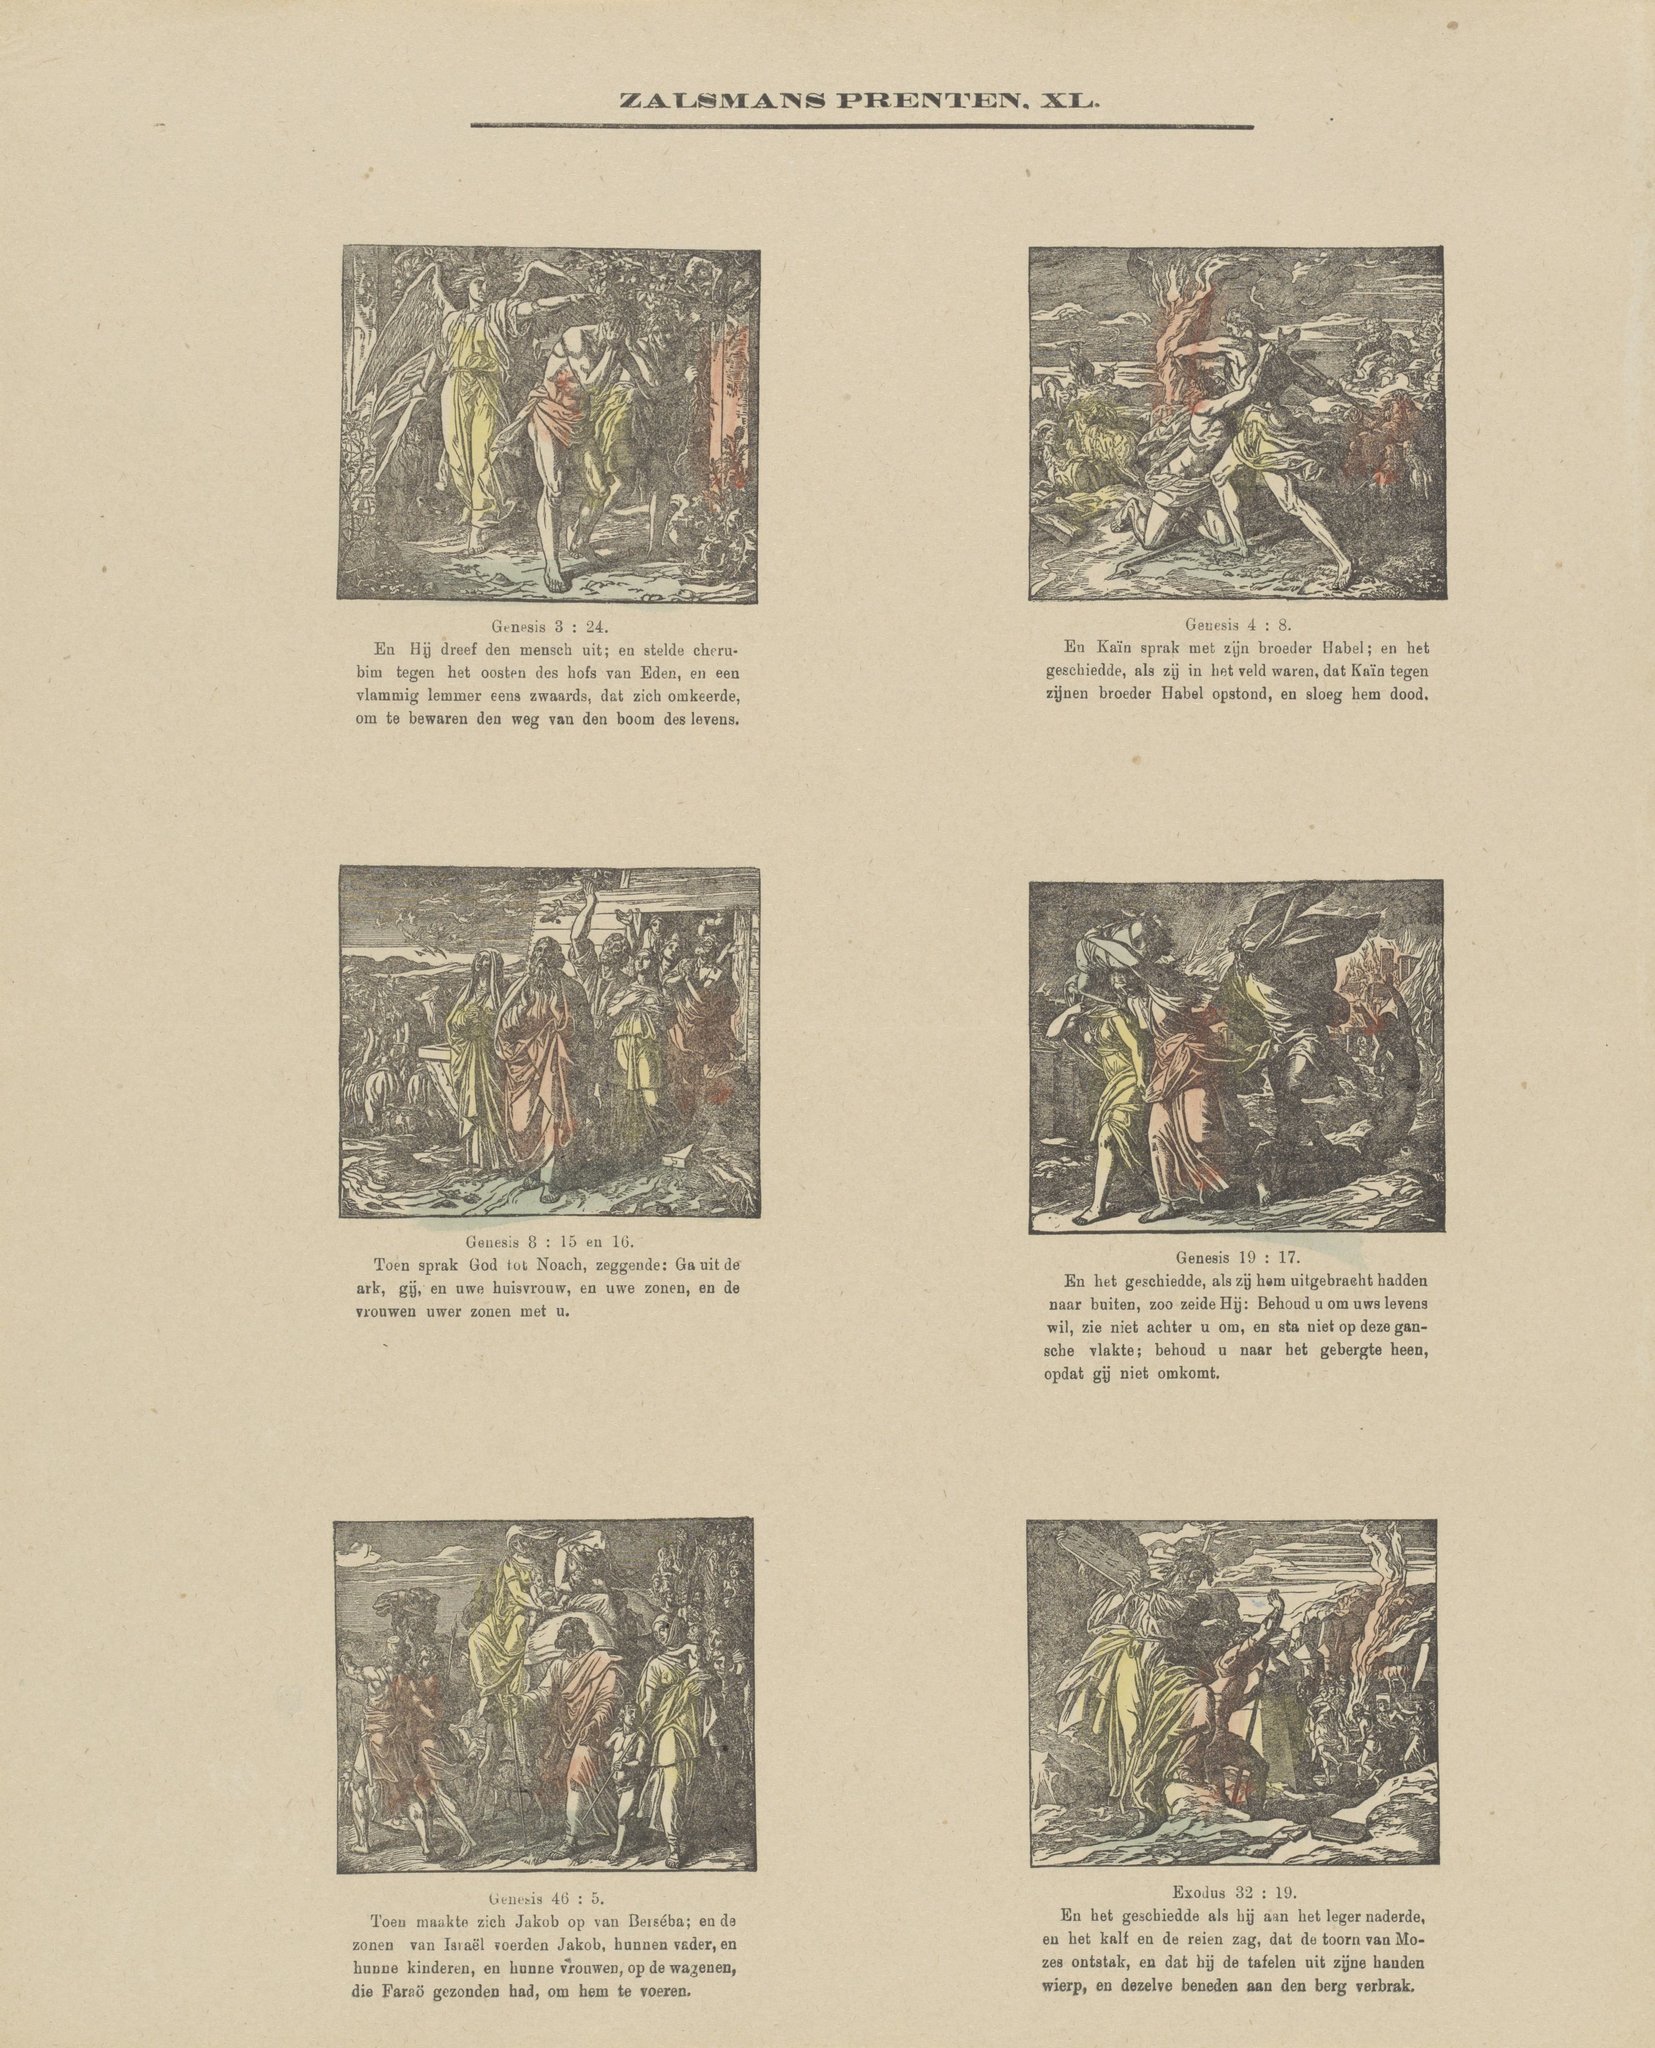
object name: print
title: Verhalen uit het Oude Testament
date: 1869-1882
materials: paper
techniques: colour, letterpress printing, engraving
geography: europe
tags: old testament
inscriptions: collector's mark: Lugt 2760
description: Blad met 6 voorstellingen van verhalen uit het Oude Testament. Onder elke afbeelding een onderschrift en een verwijzing naar de bijbehorende Bijbeltekst. Genummerd midden boven: XL.